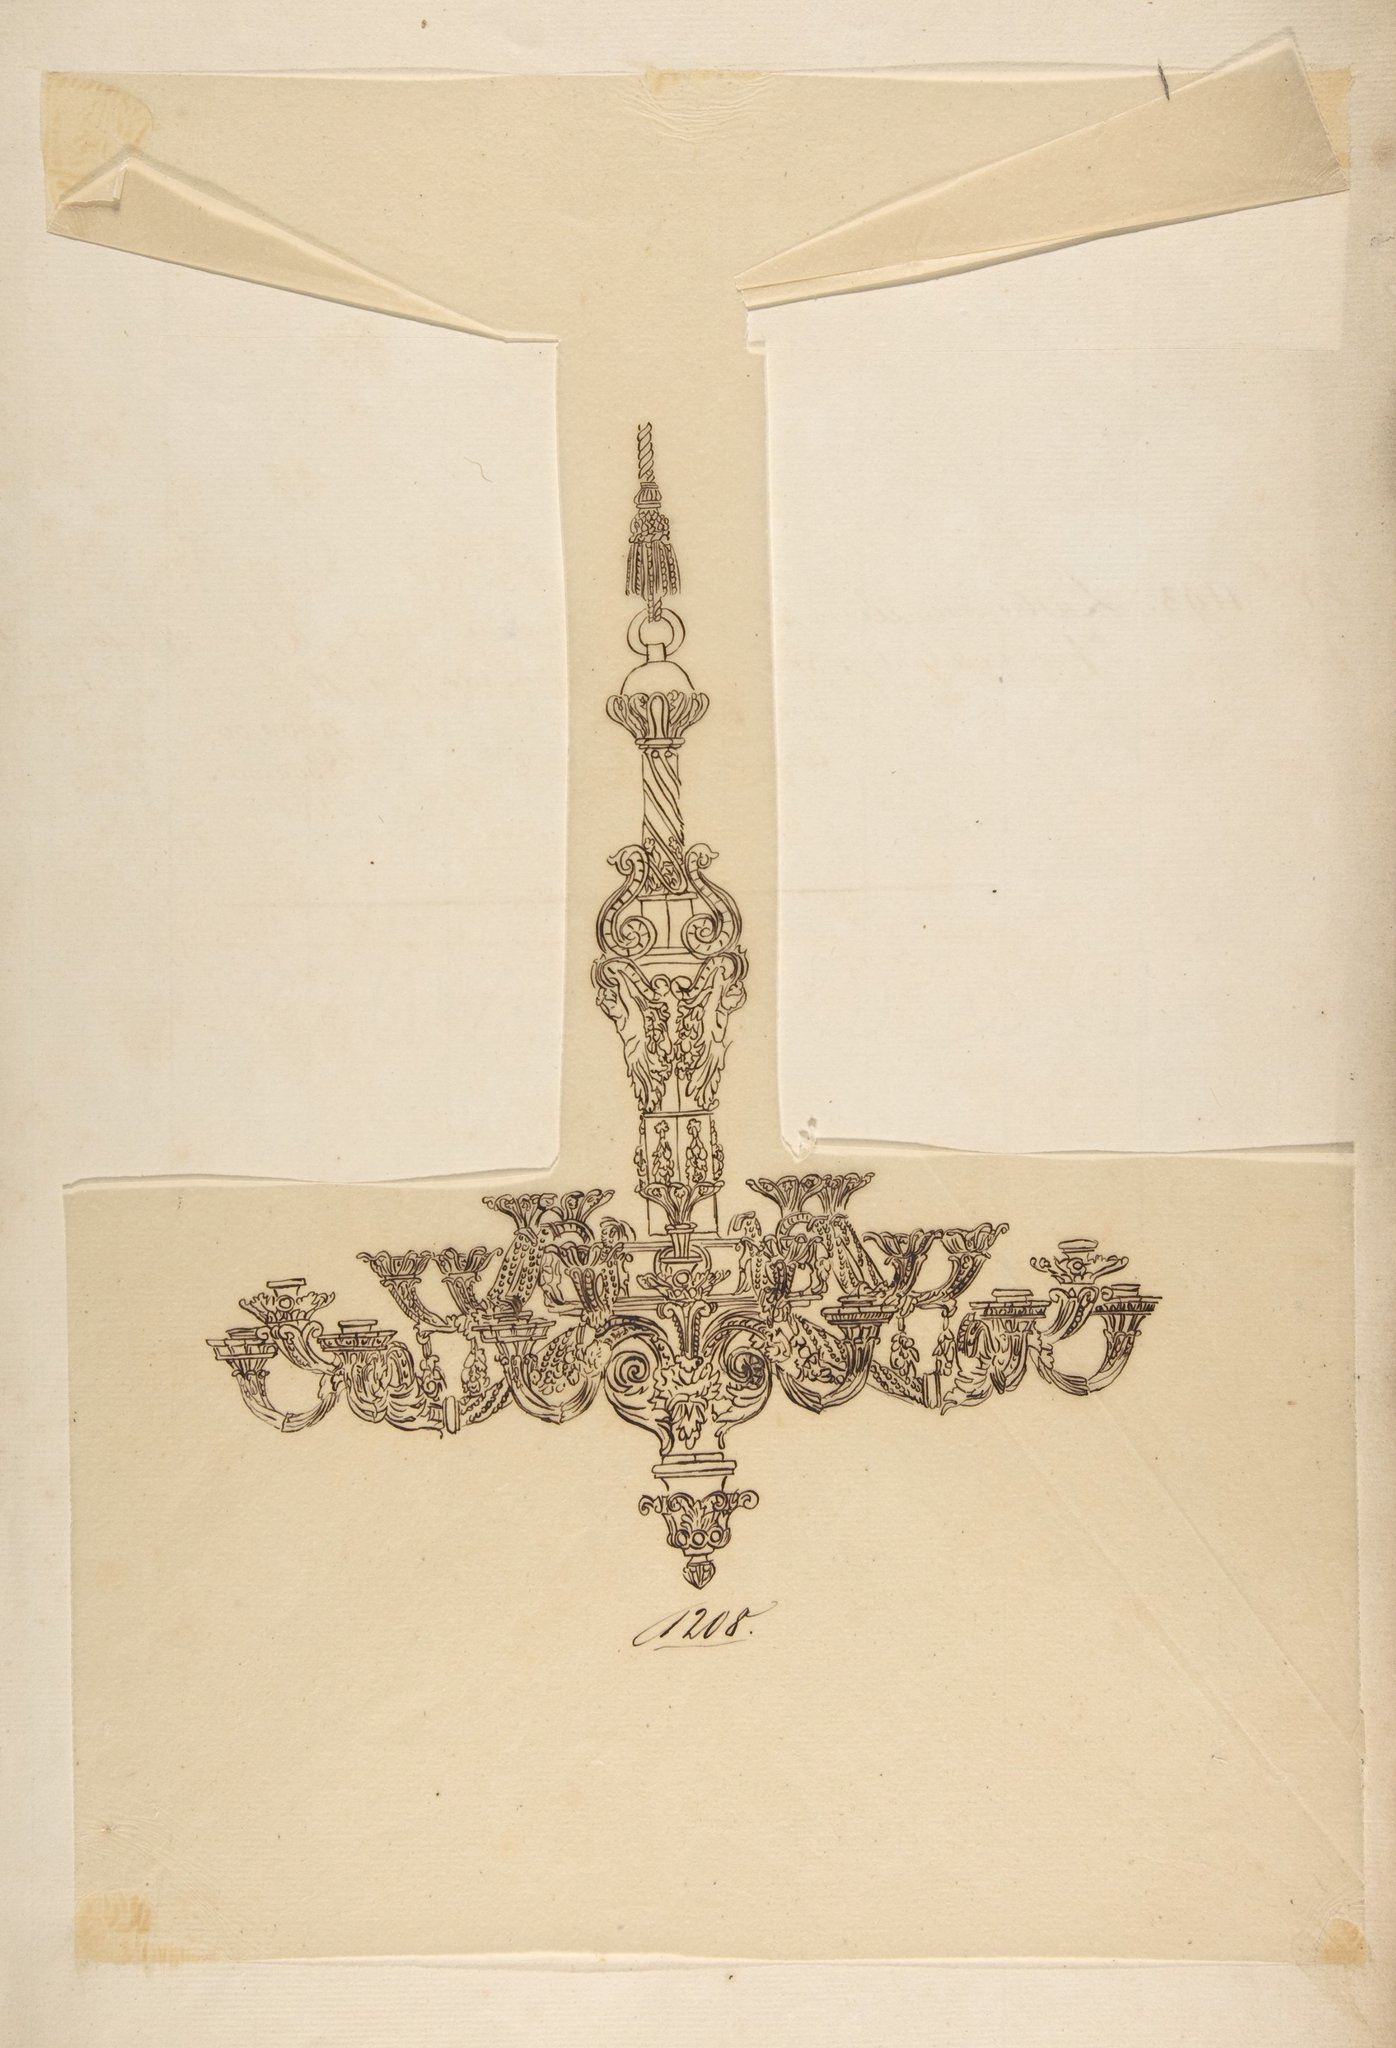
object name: drawing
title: Design for a Chandelier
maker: anonymous, french, 19th century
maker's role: artist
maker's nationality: french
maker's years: 1800-1900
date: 1801-1900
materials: ink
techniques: pen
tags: chandelier